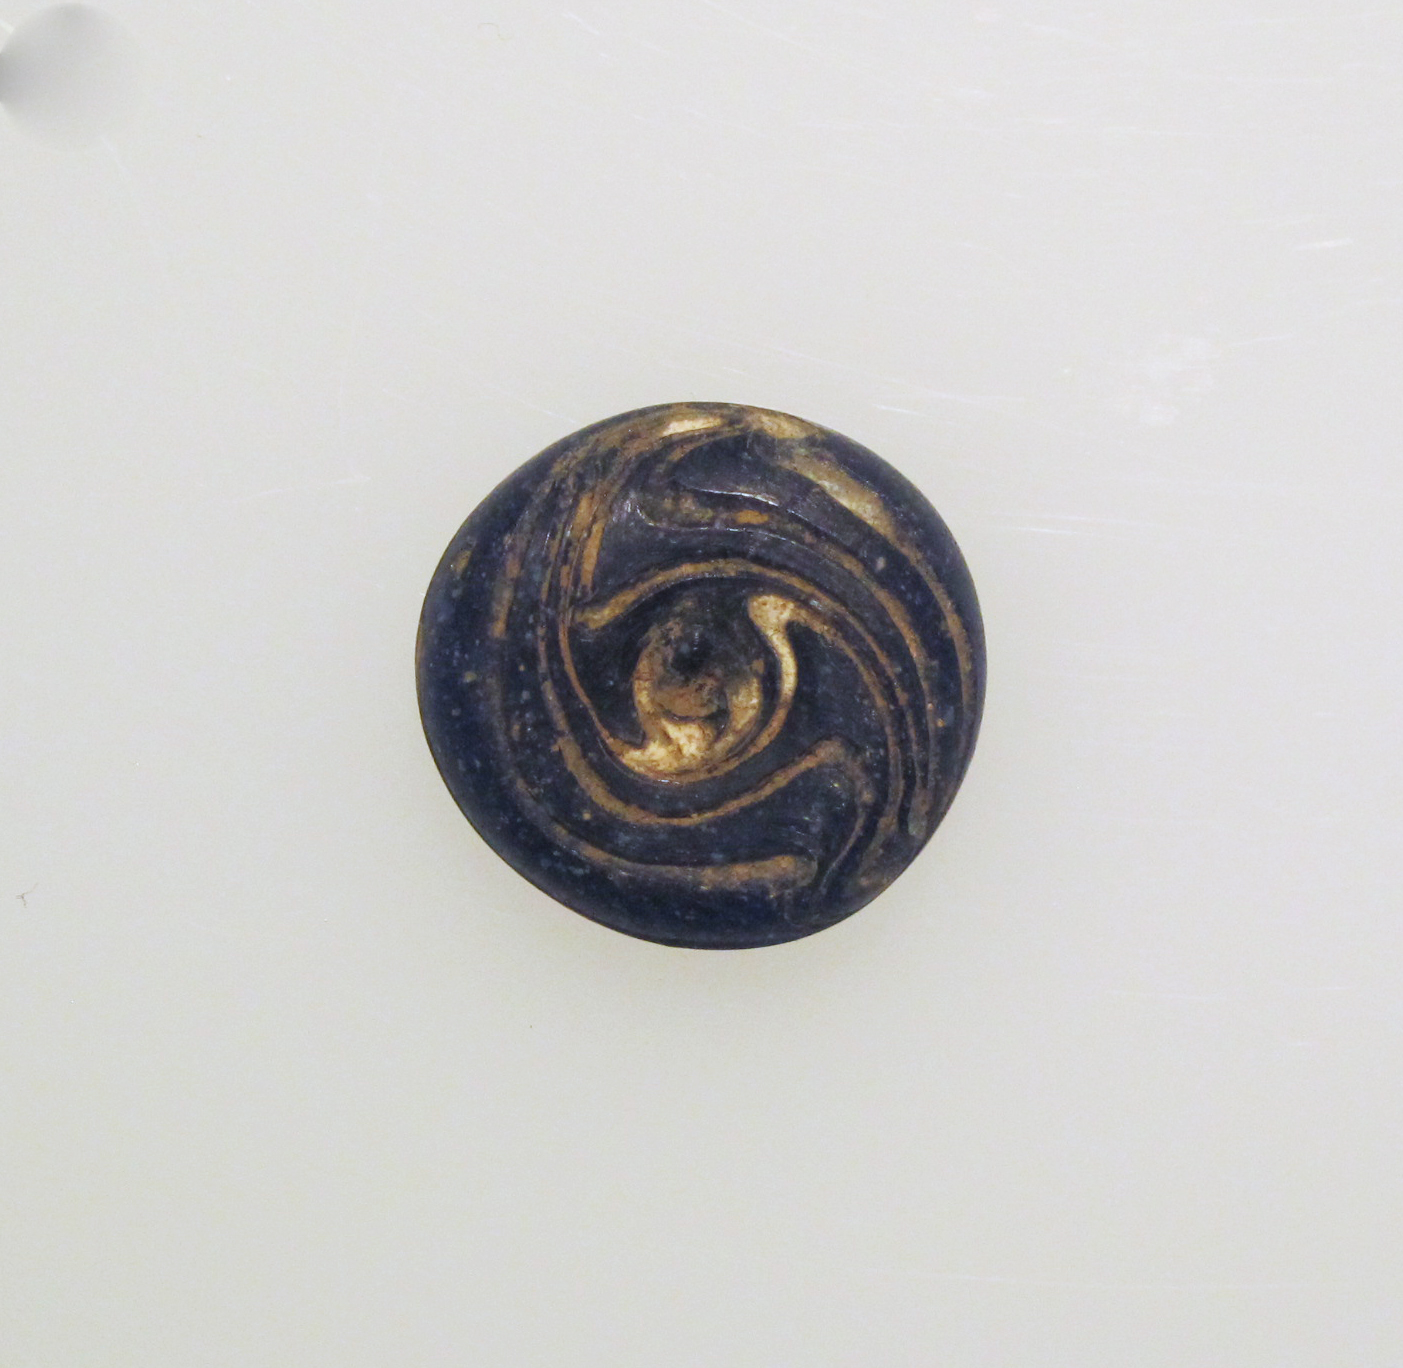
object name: pinhead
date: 7000 BCE-330 CE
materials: glass